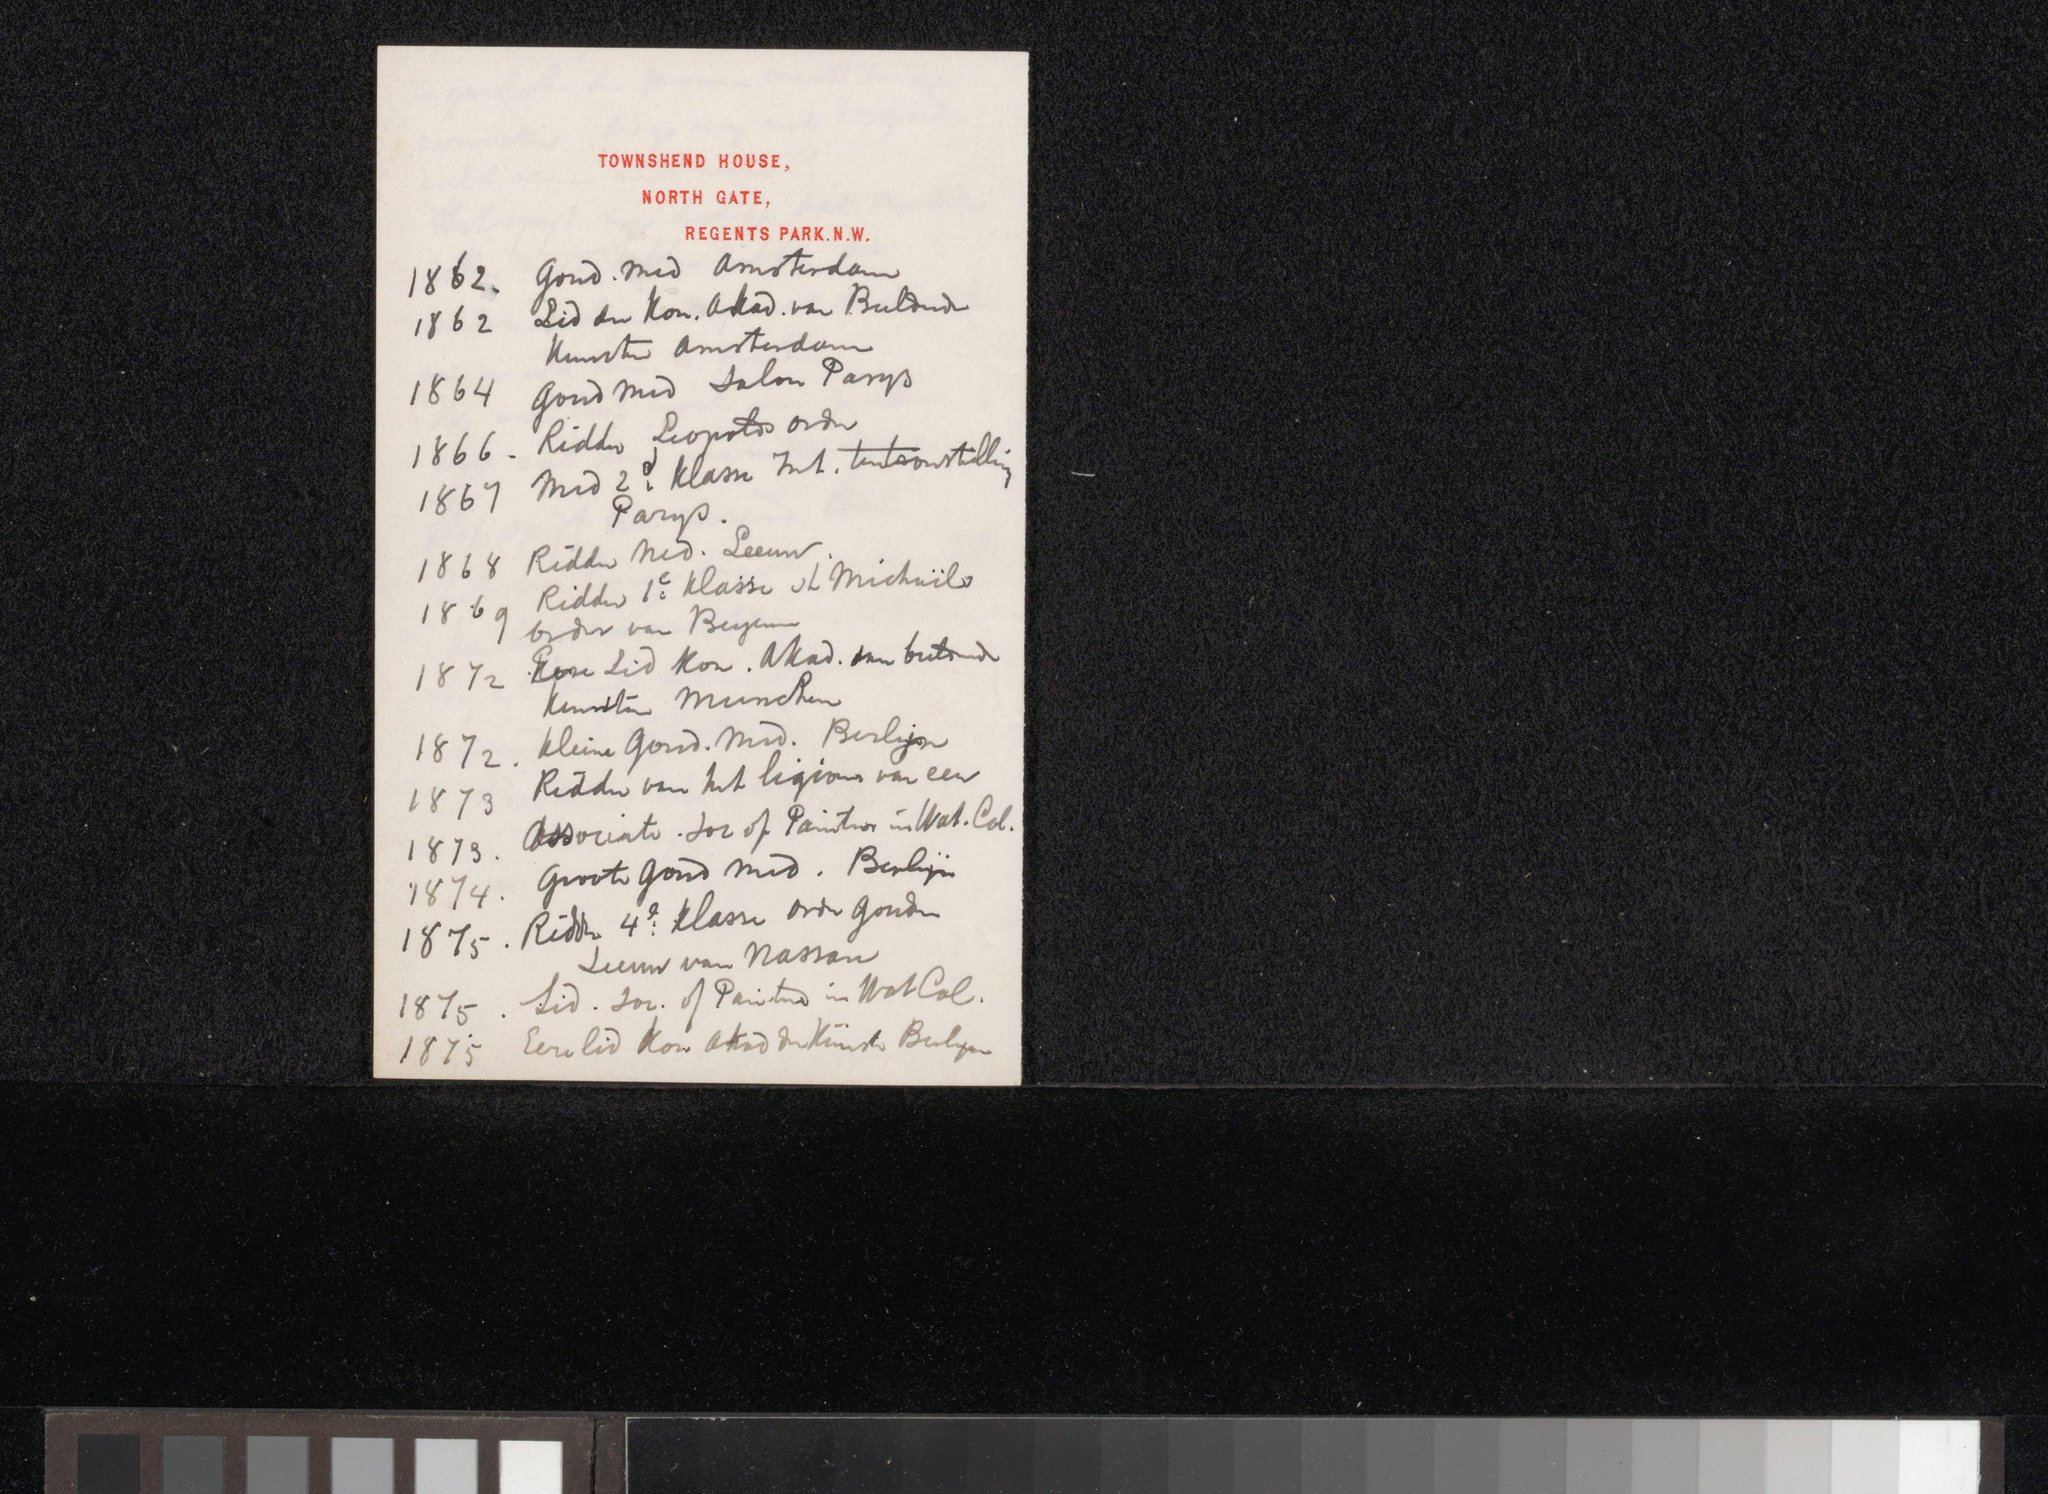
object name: letter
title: Brief aan Carel Vosmaer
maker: lourens alma tadema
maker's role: draughtsman, print maker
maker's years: 1836-1912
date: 1881-1888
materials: ink, paper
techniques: pen, printing, writing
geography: london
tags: the hague, carel vosmaer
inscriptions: watermark